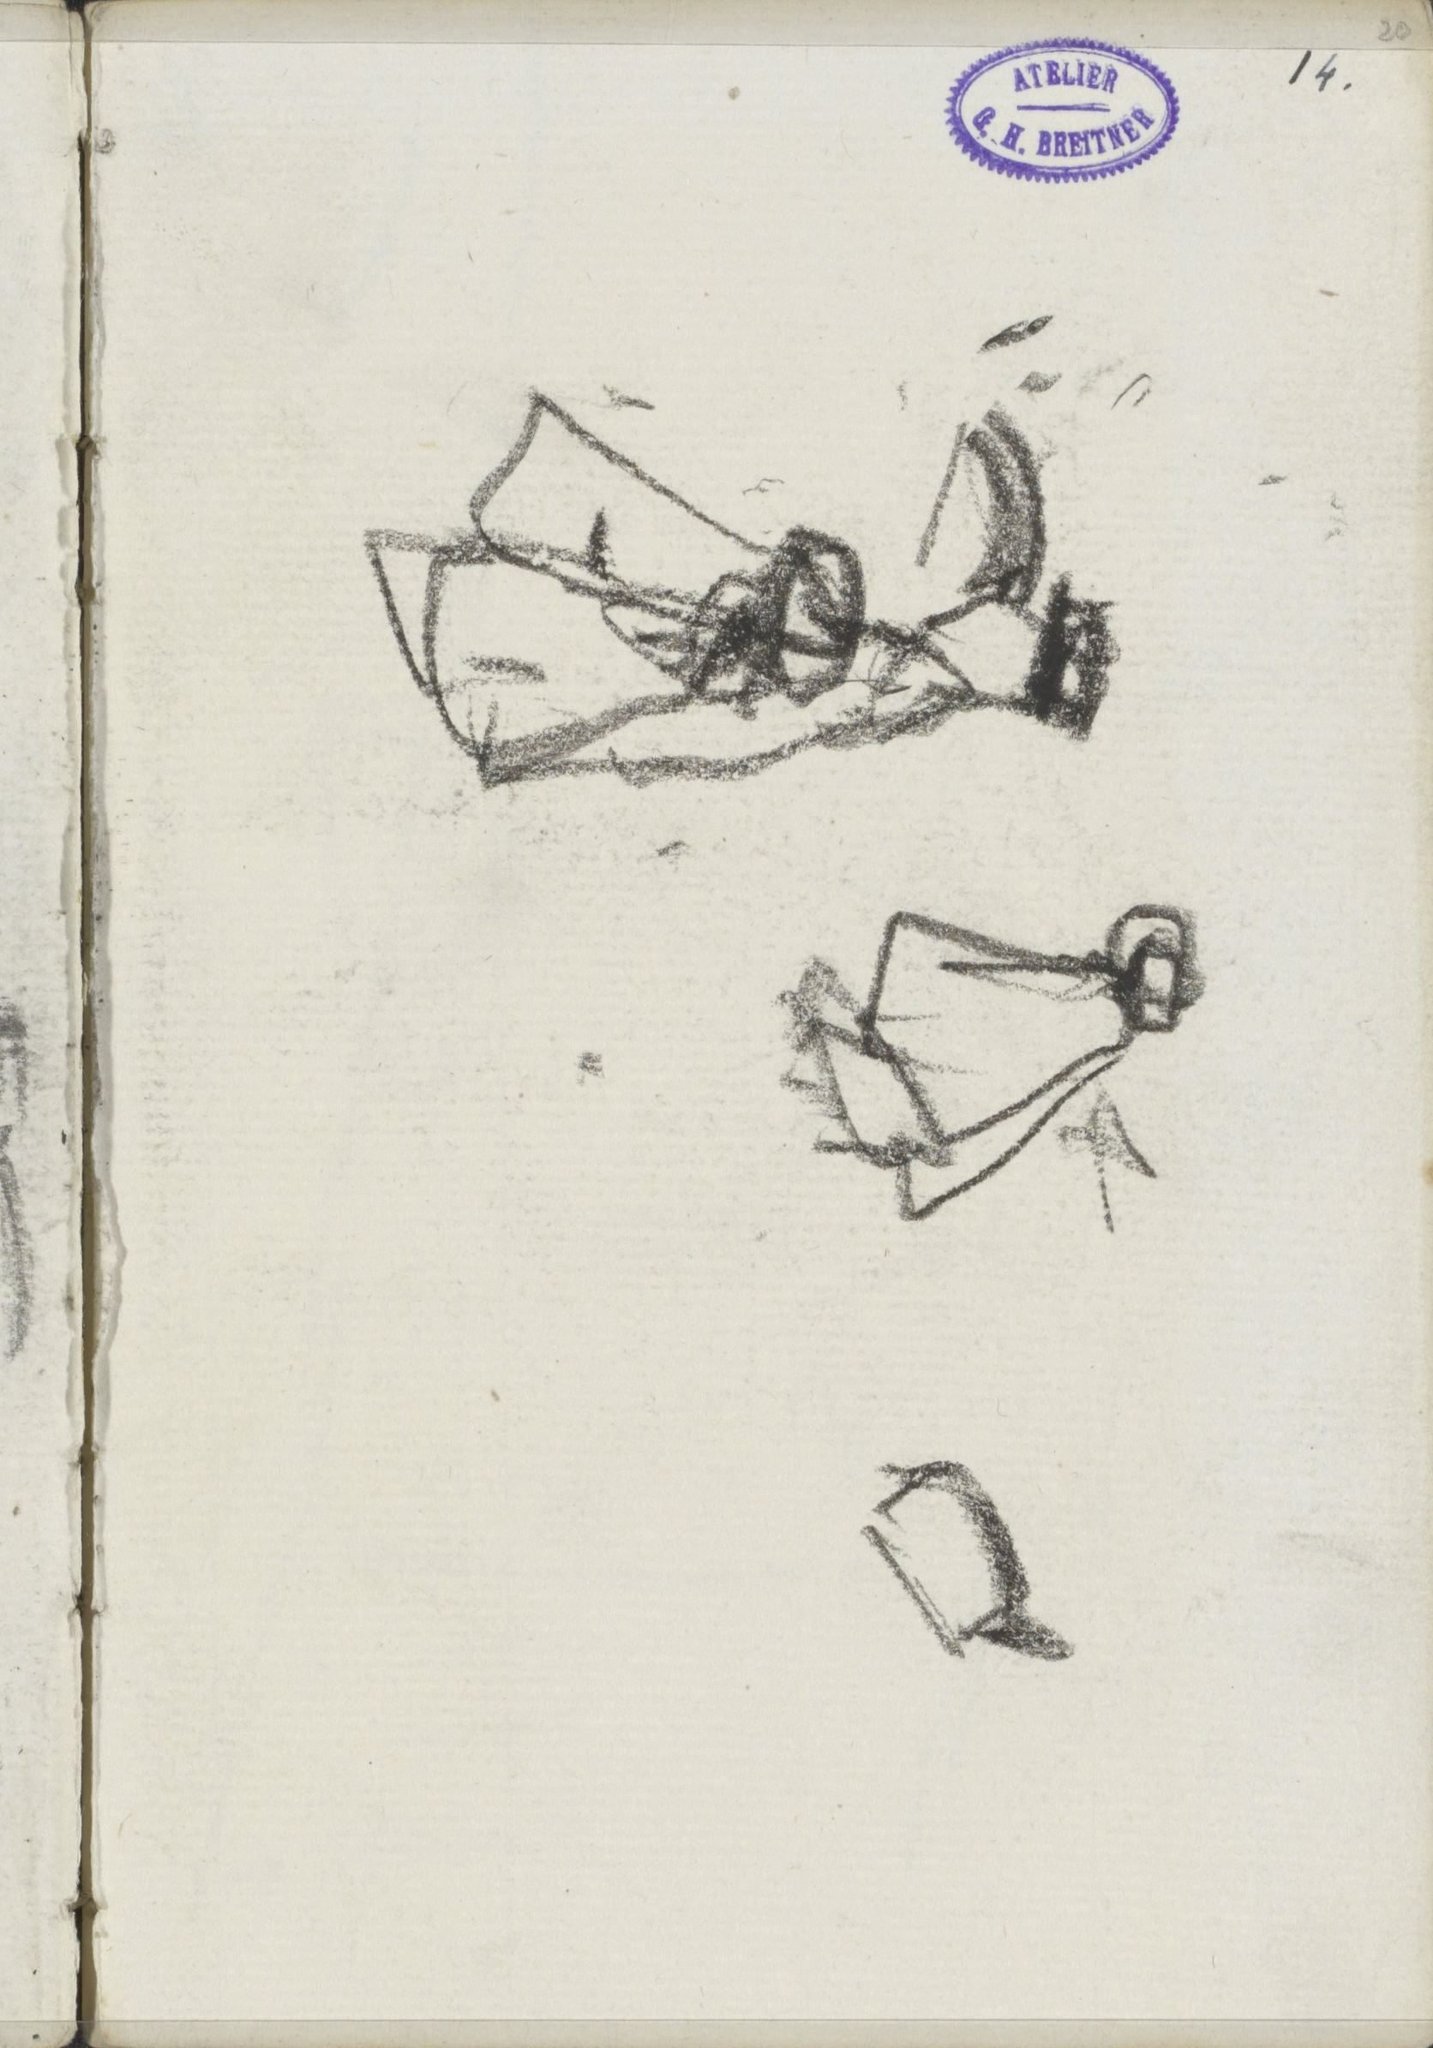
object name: sketchbook leaf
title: Studies van vrouwen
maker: george hendrik breitner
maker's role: draughtsman, painter, print maker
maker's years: 1857-1923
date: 1891-1894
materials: chalk, paper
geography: amsterdam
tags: adult woman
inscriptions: workshop stamp: Lugt 291d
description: Pagina 20 uit een schetsboek met 15 bladen.